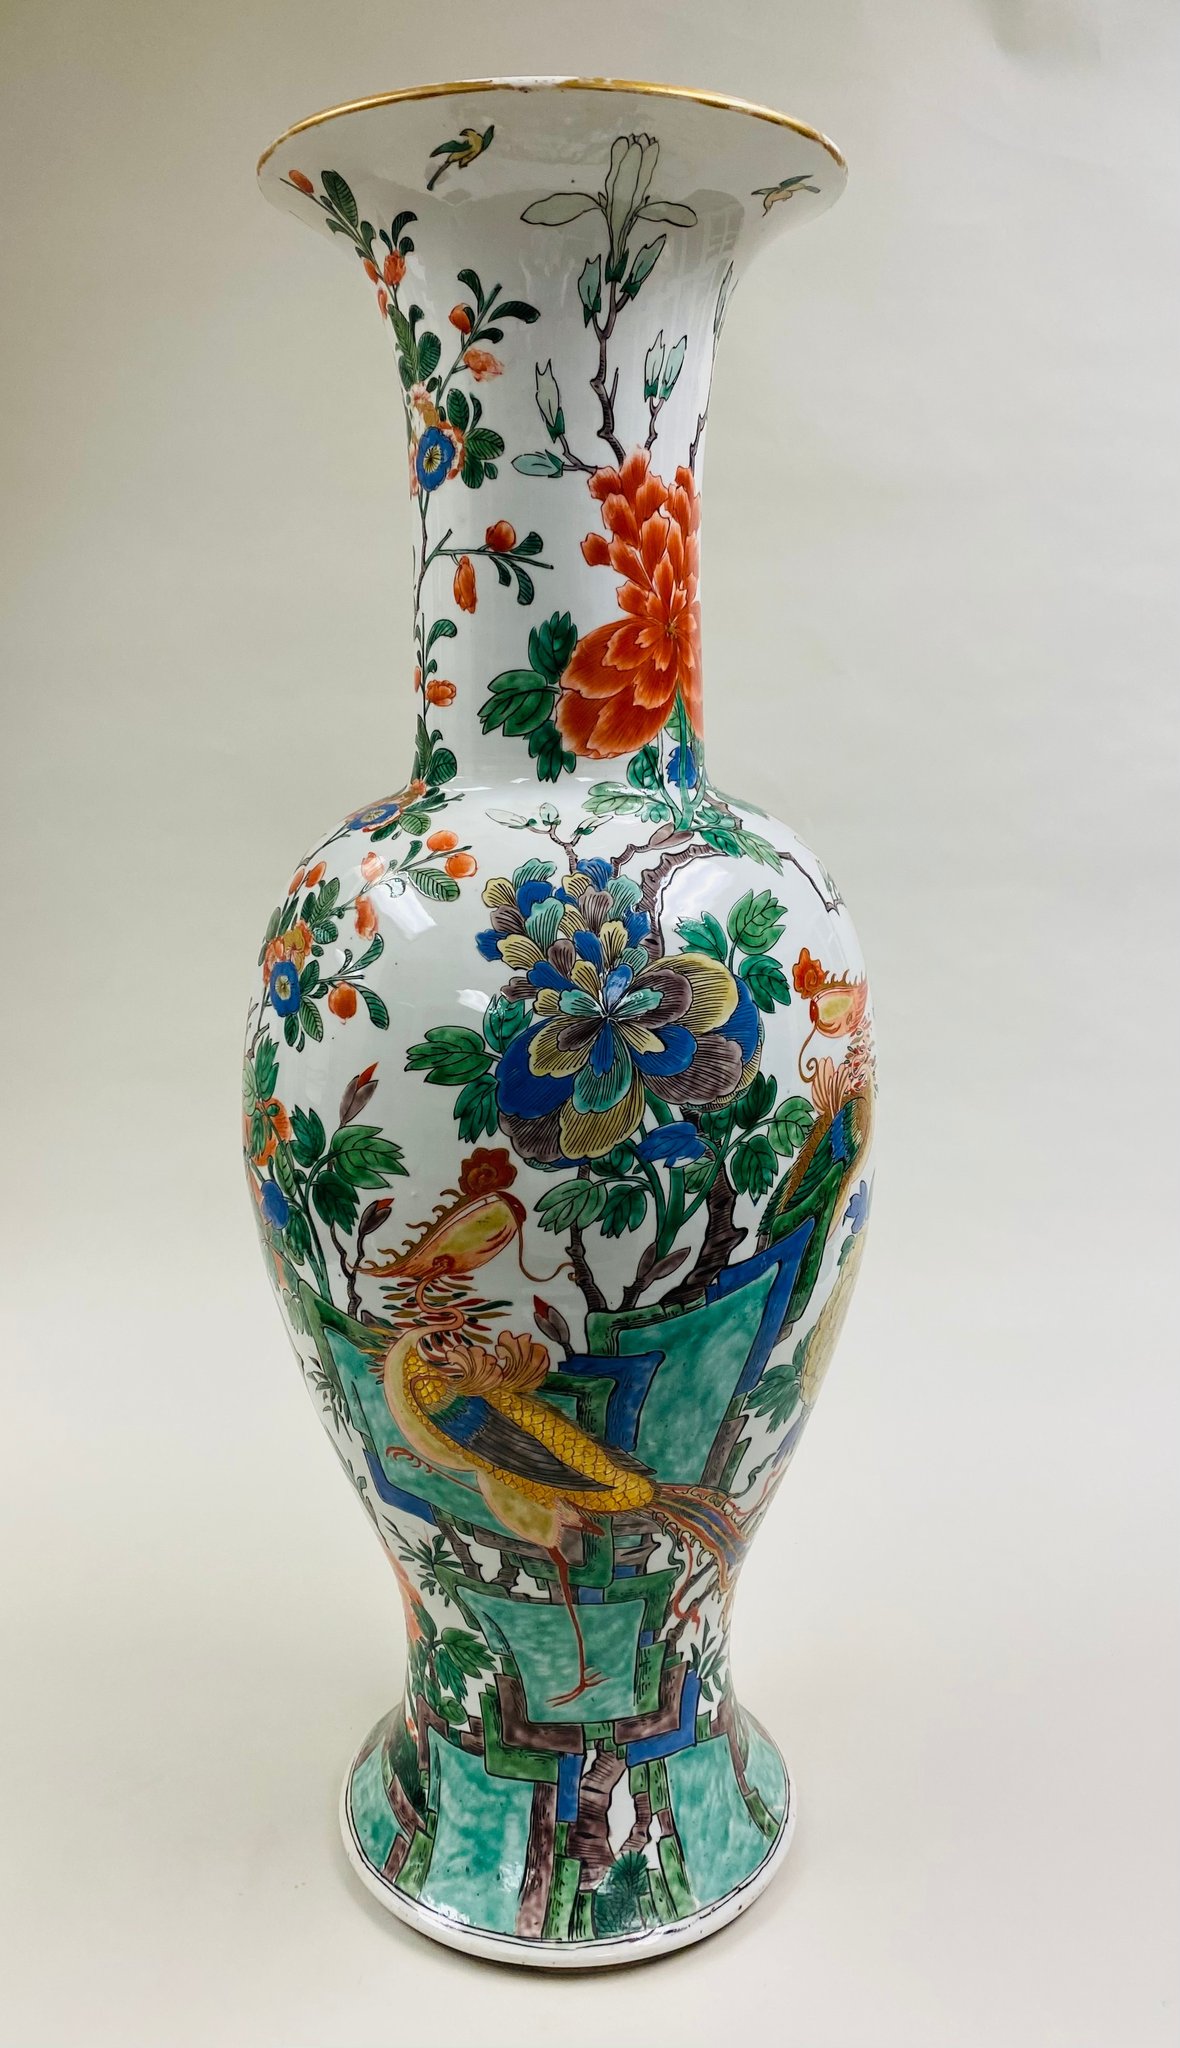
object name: vase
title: Vase with birds and flowers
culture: chinese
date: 1667-1733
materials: enamel, porcelain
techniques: overglaze, painting, polychrome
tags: birds,flowers